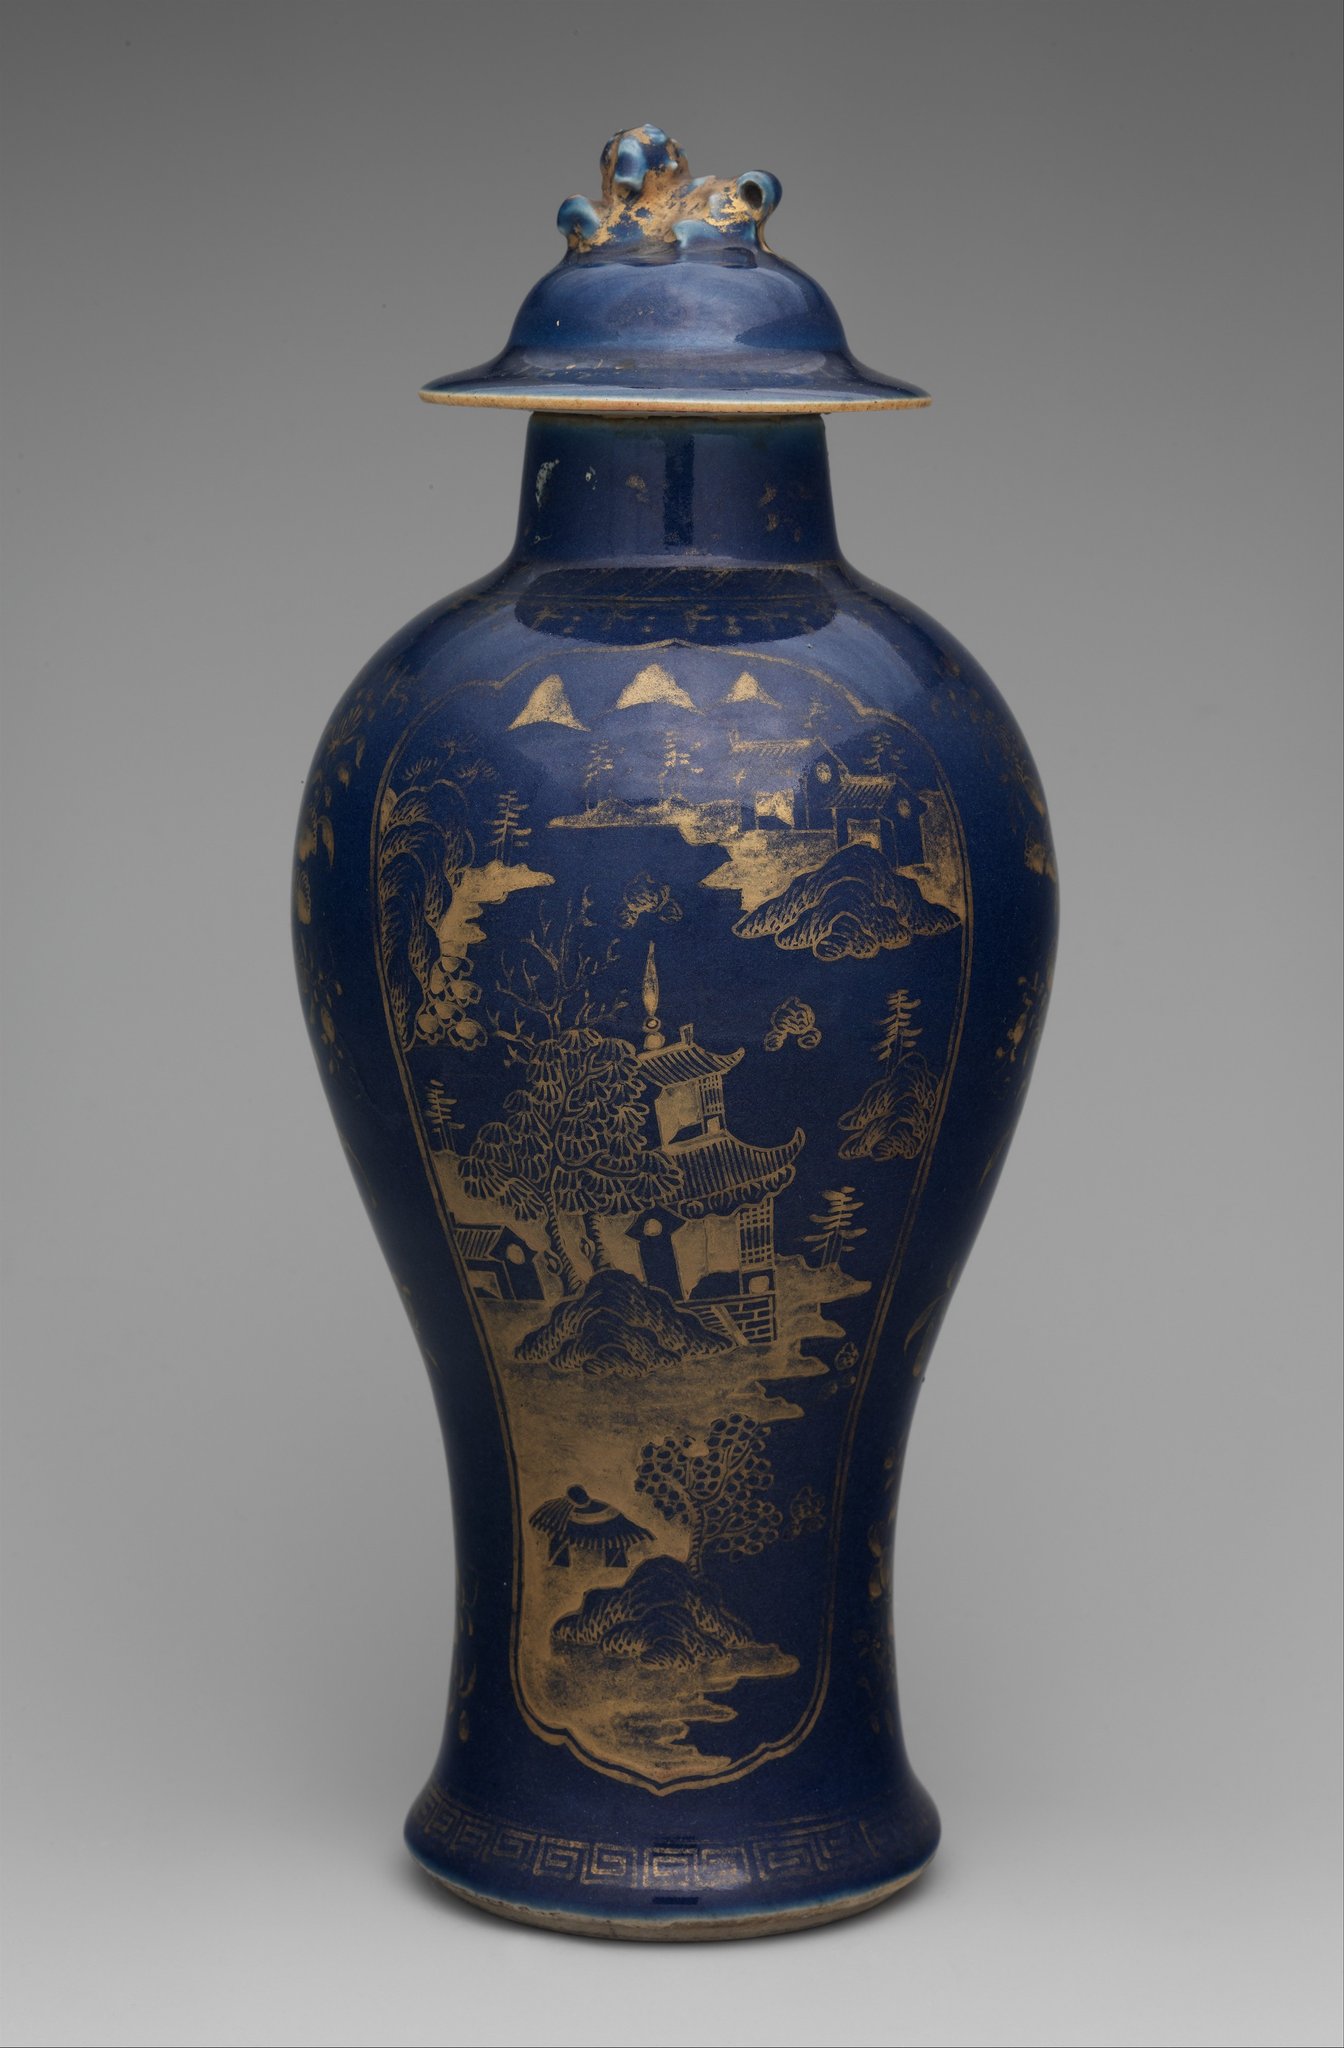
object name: vase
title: Covered Vase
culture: chinese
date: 1770-1795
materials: porcelain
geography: china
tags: landscapes